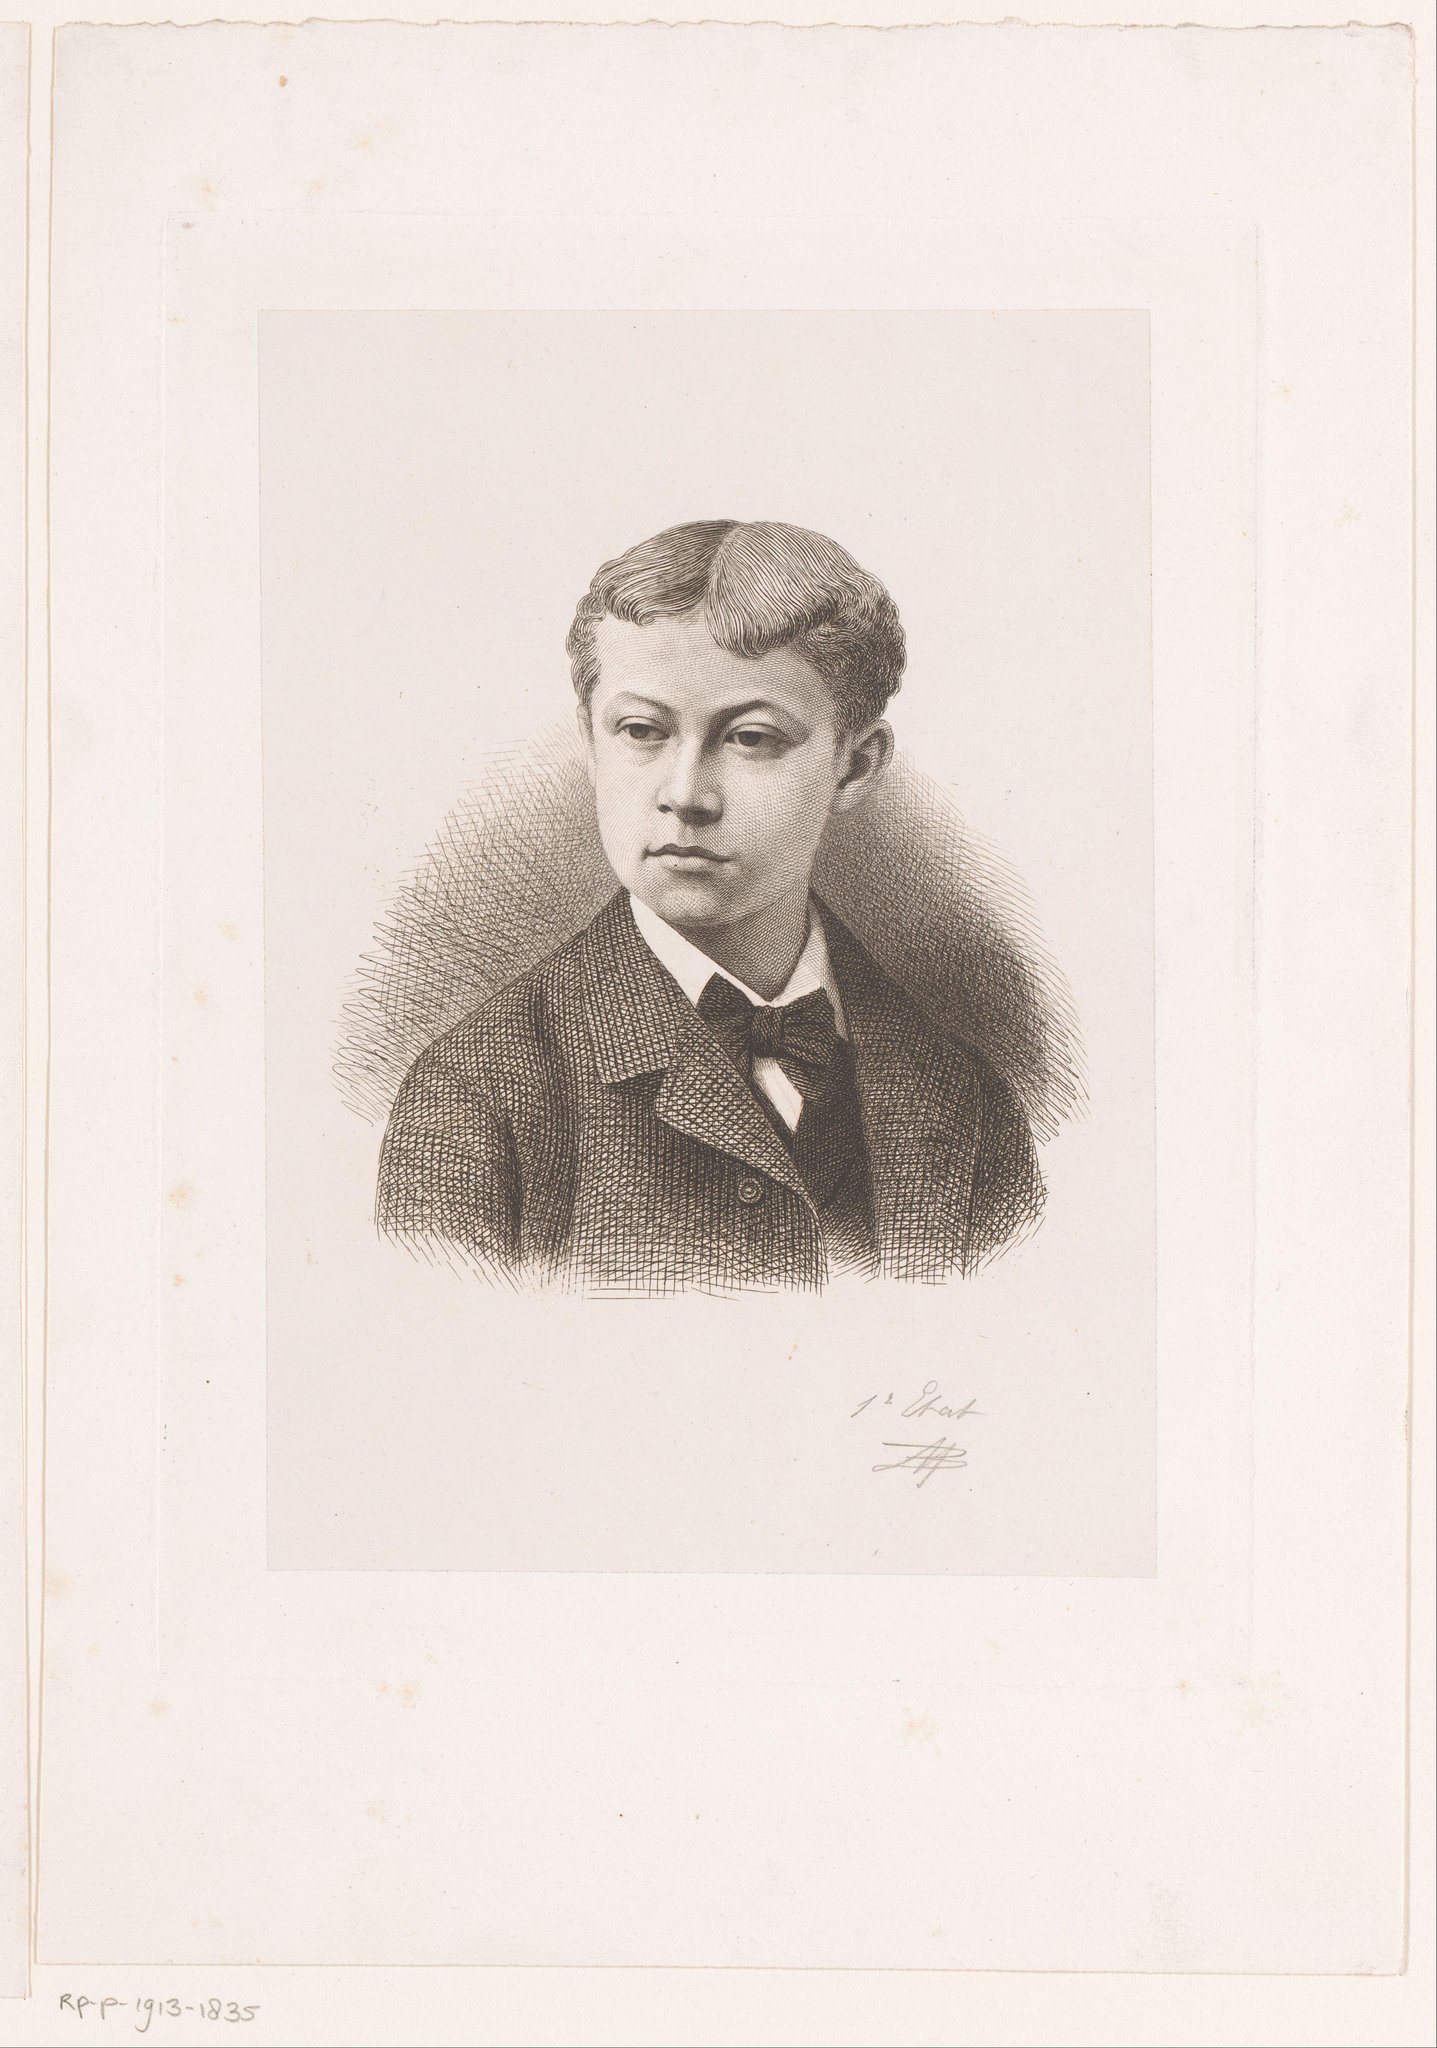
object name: print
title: Portret van een onbekende jongen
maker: jean baptiste pierre michiels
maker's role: print maker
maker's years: 1821-1890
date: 1831-1890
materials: paper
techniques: etching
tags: historical persons, youth, adolescent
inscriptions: collector's mark: Lugt 2228, inscription: ‘1e Etat’